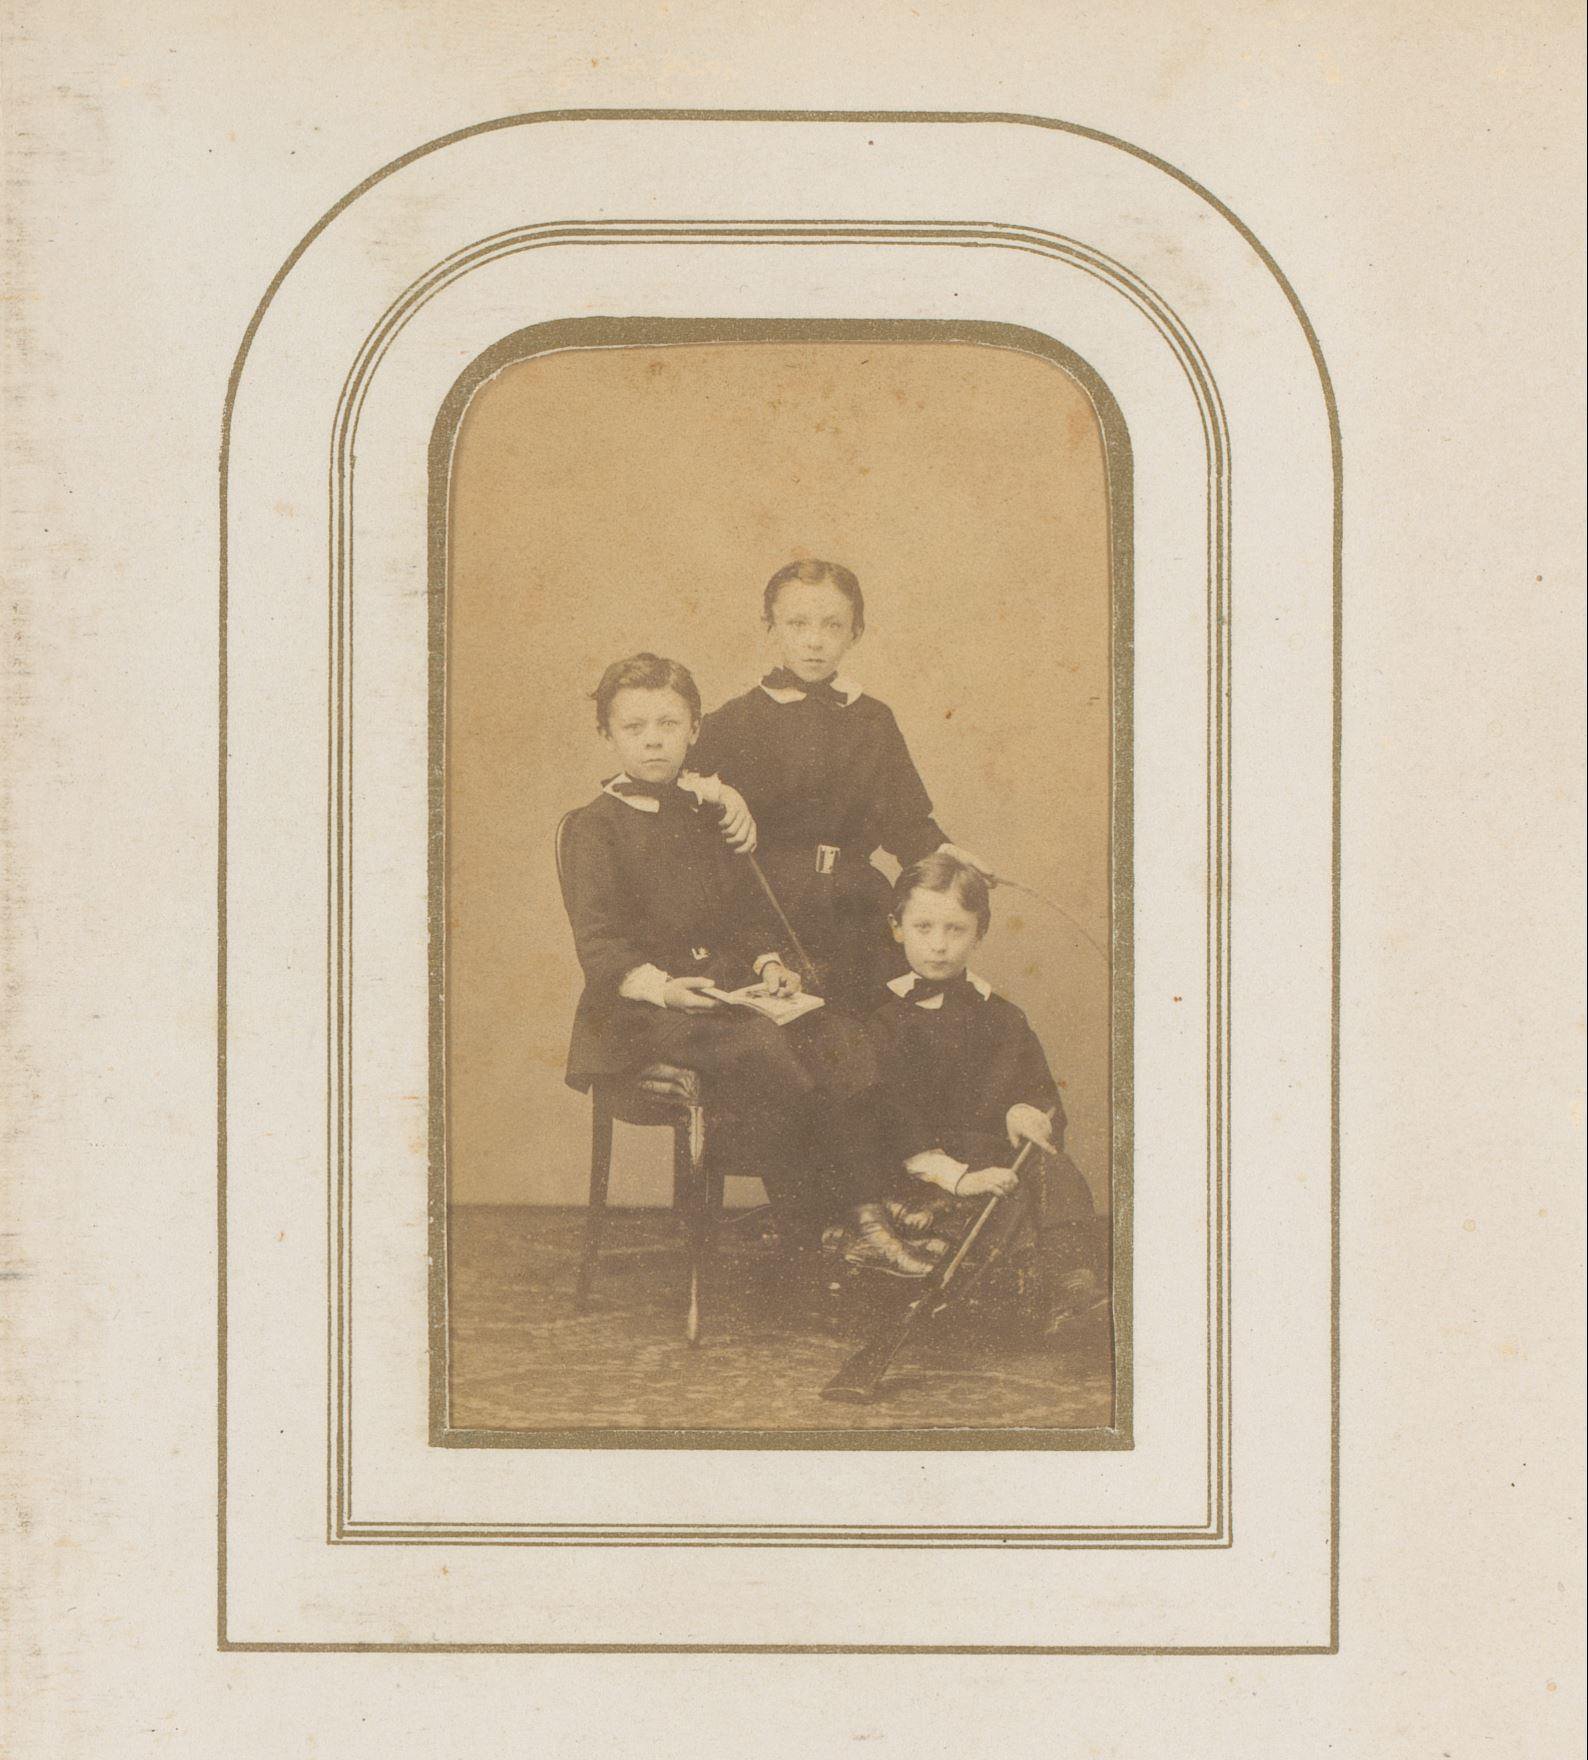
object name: carte de visite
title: Groepsportret van drie kinderen met geweer, stok en hoepel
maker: jules géruzet (fotograaf)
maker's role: fotograaf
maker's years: 1817-1874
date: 1859-1874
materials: cardboard, photographic support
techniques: albumen print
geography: brussels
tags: child, (bowling a) hoop, firearms, anonymous historical persons portrayed in a group, in a group-portrait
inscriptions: inscription: ‘Atelier de Photographie/ de J. Géruzet, Edituer d'Estampes/ 27bis, Rue de l'Ecuyer/ Bruxelles’